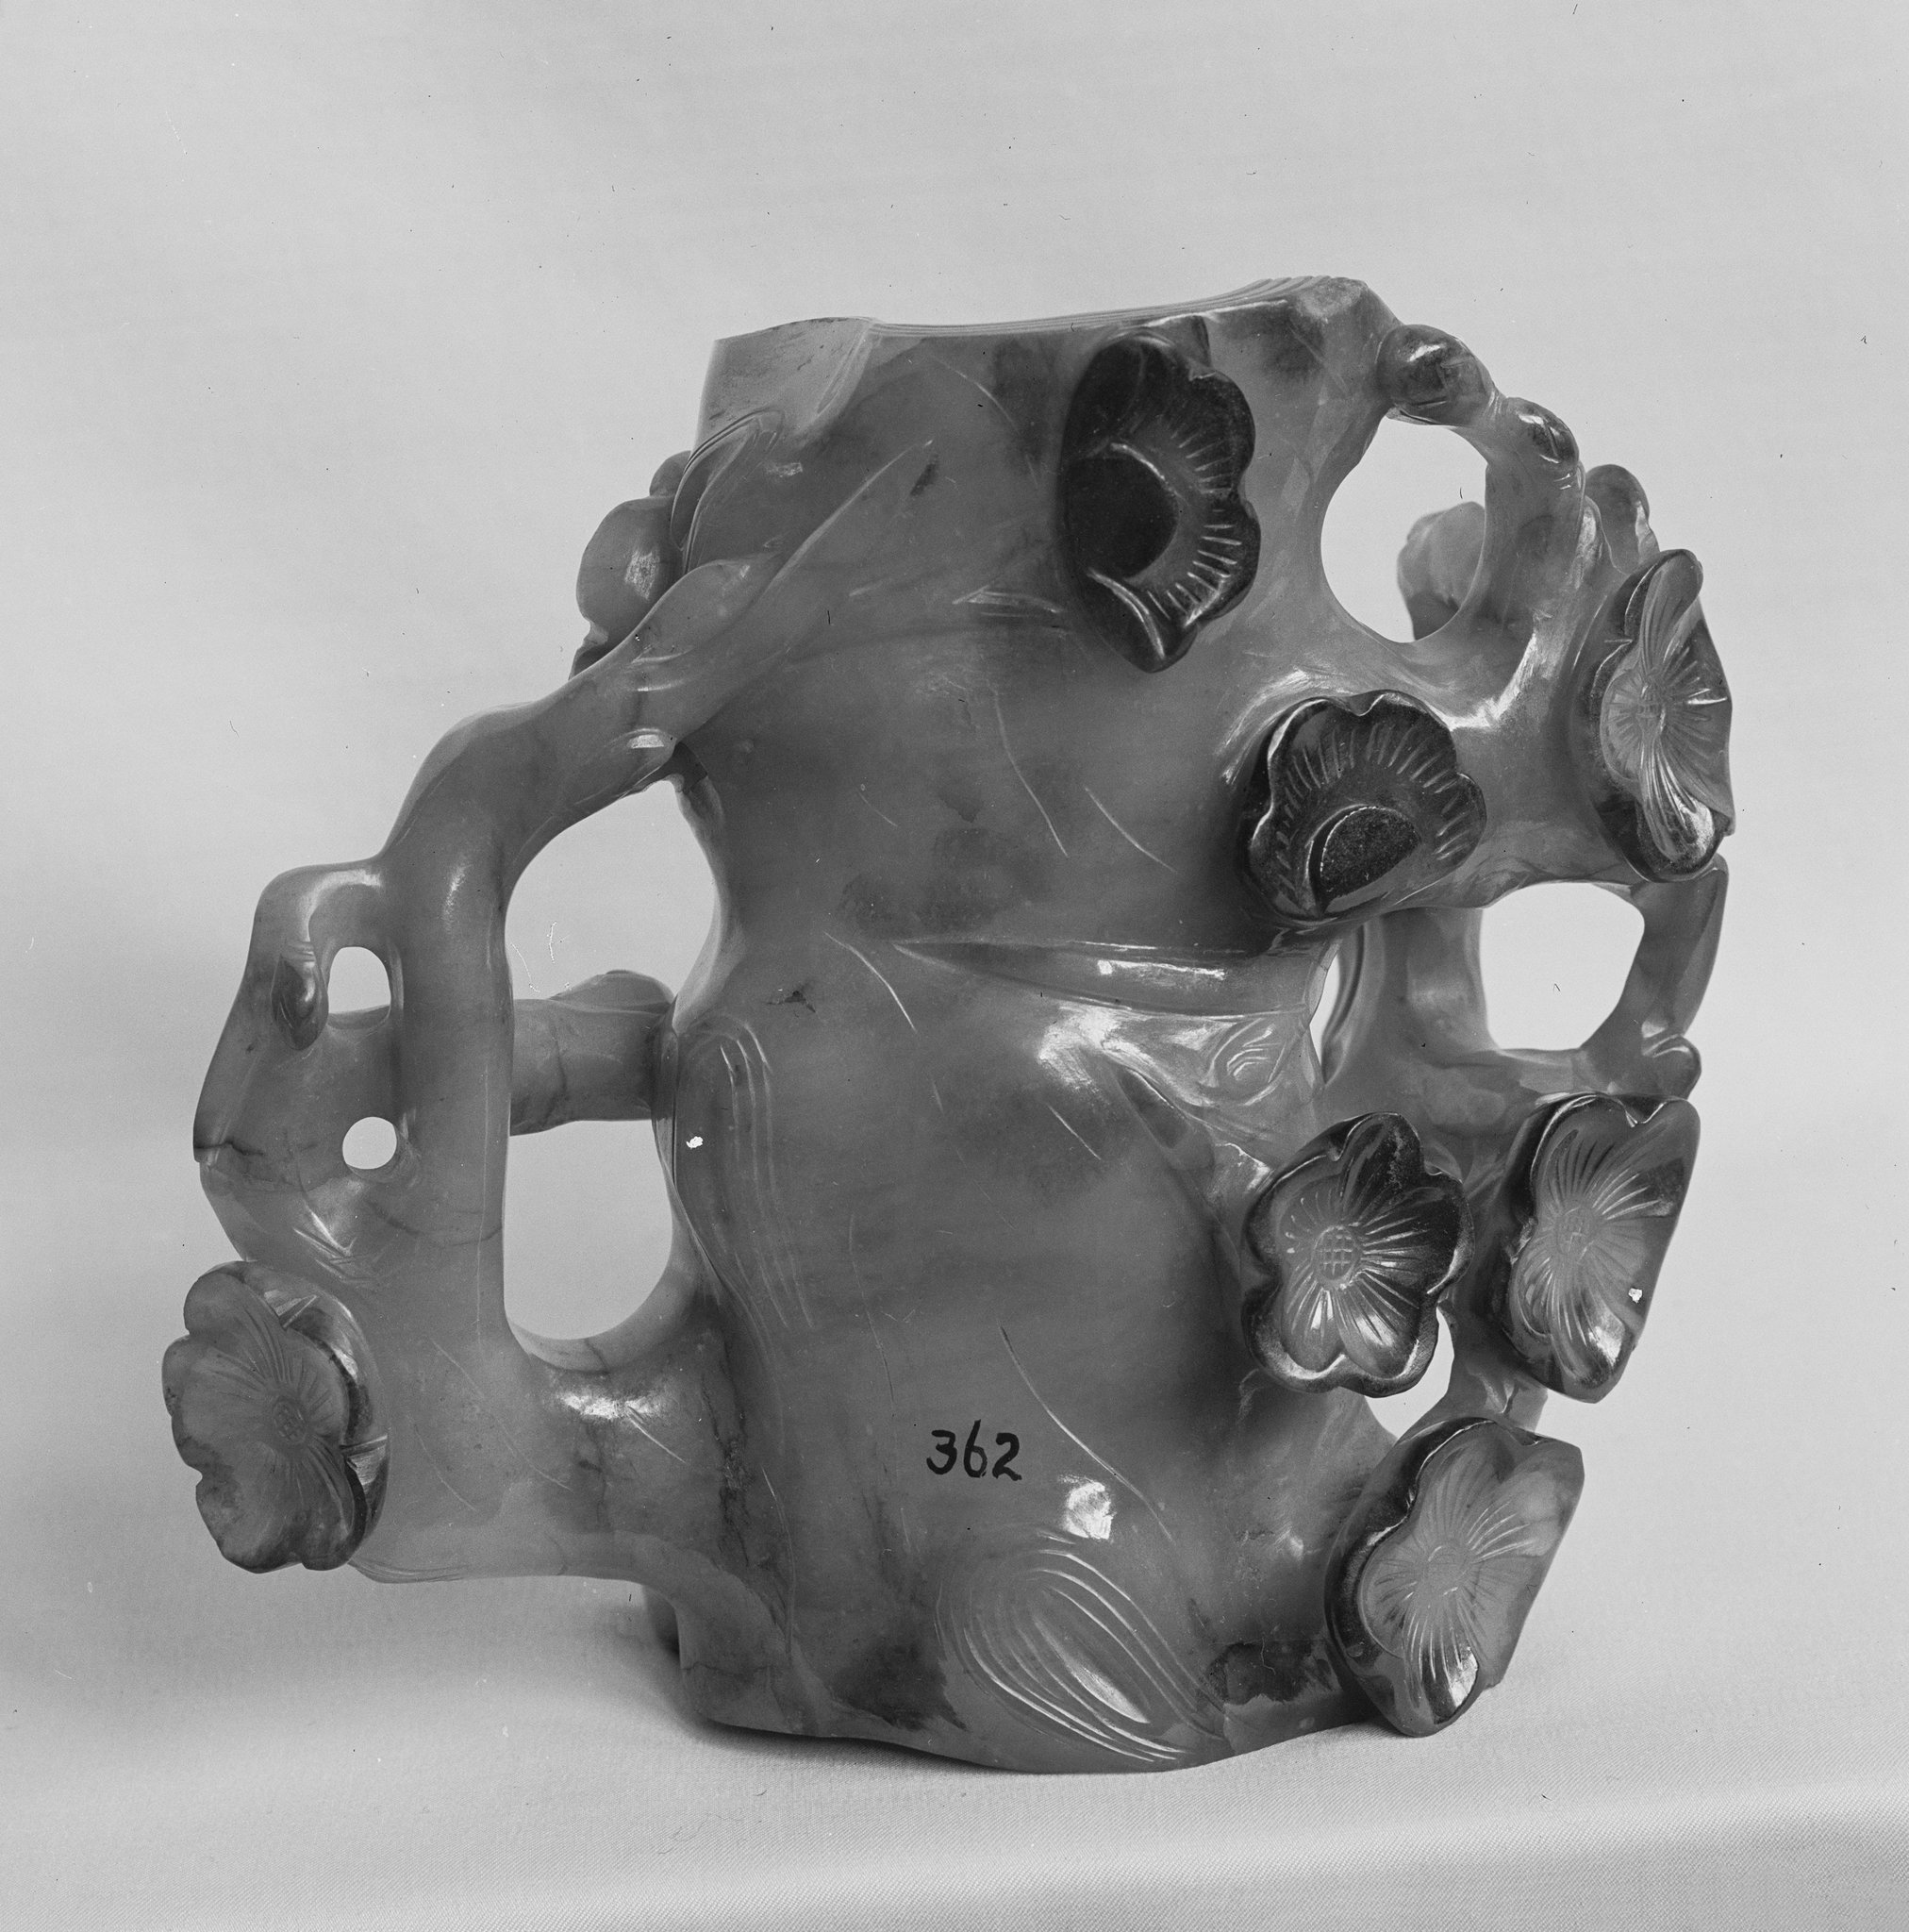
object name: vase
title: Plum-Tree Vase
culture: chinese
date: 1368-1644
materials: jade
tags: flowers